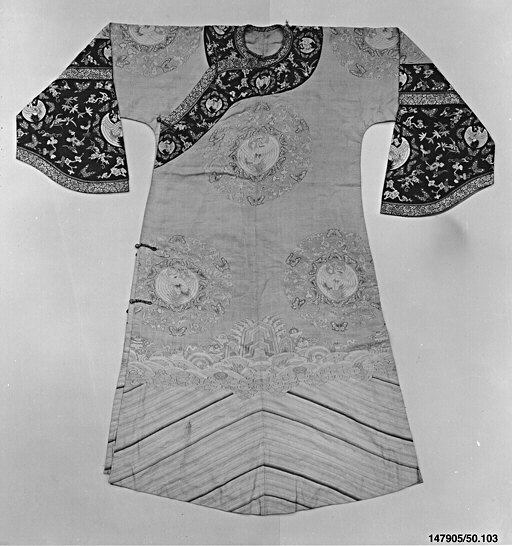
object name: robe, birthday or ceremonial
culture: chinese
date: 1909-1911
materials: silk